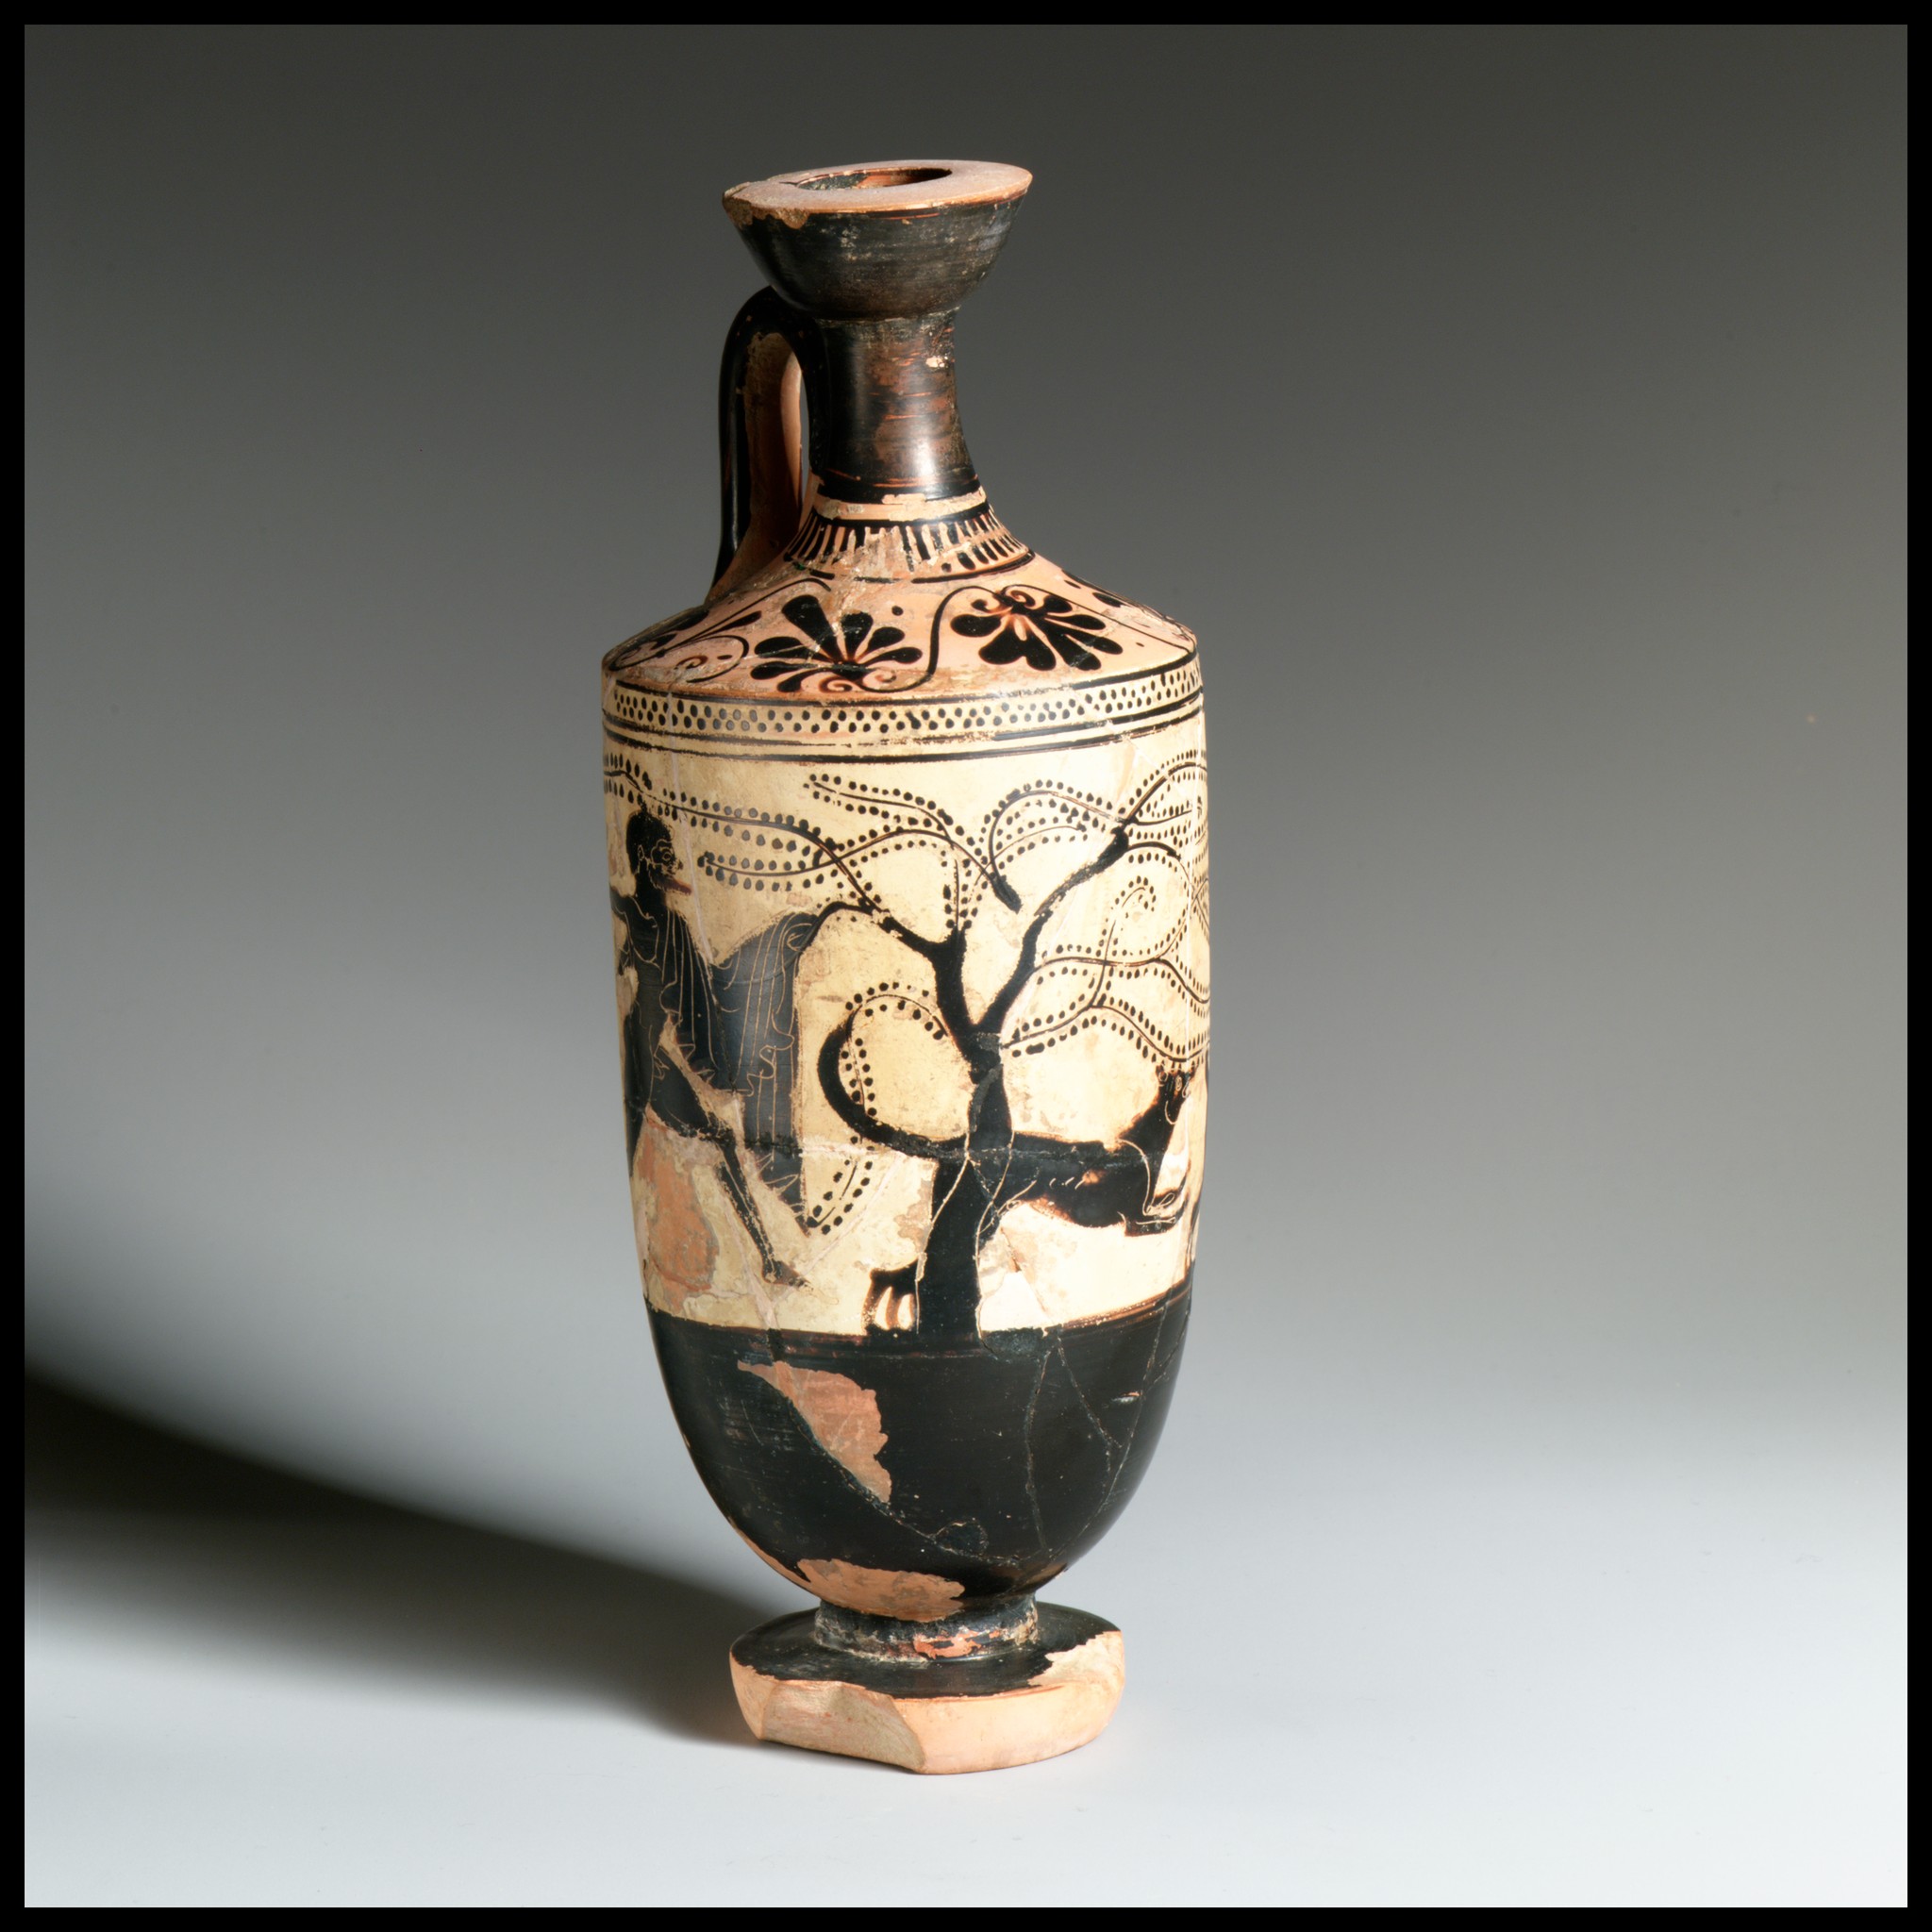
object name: lekythos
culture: greek, attic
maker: athena painter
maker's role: artist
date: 480 BCE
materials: terracotta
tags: men,hunting,dogs,trees